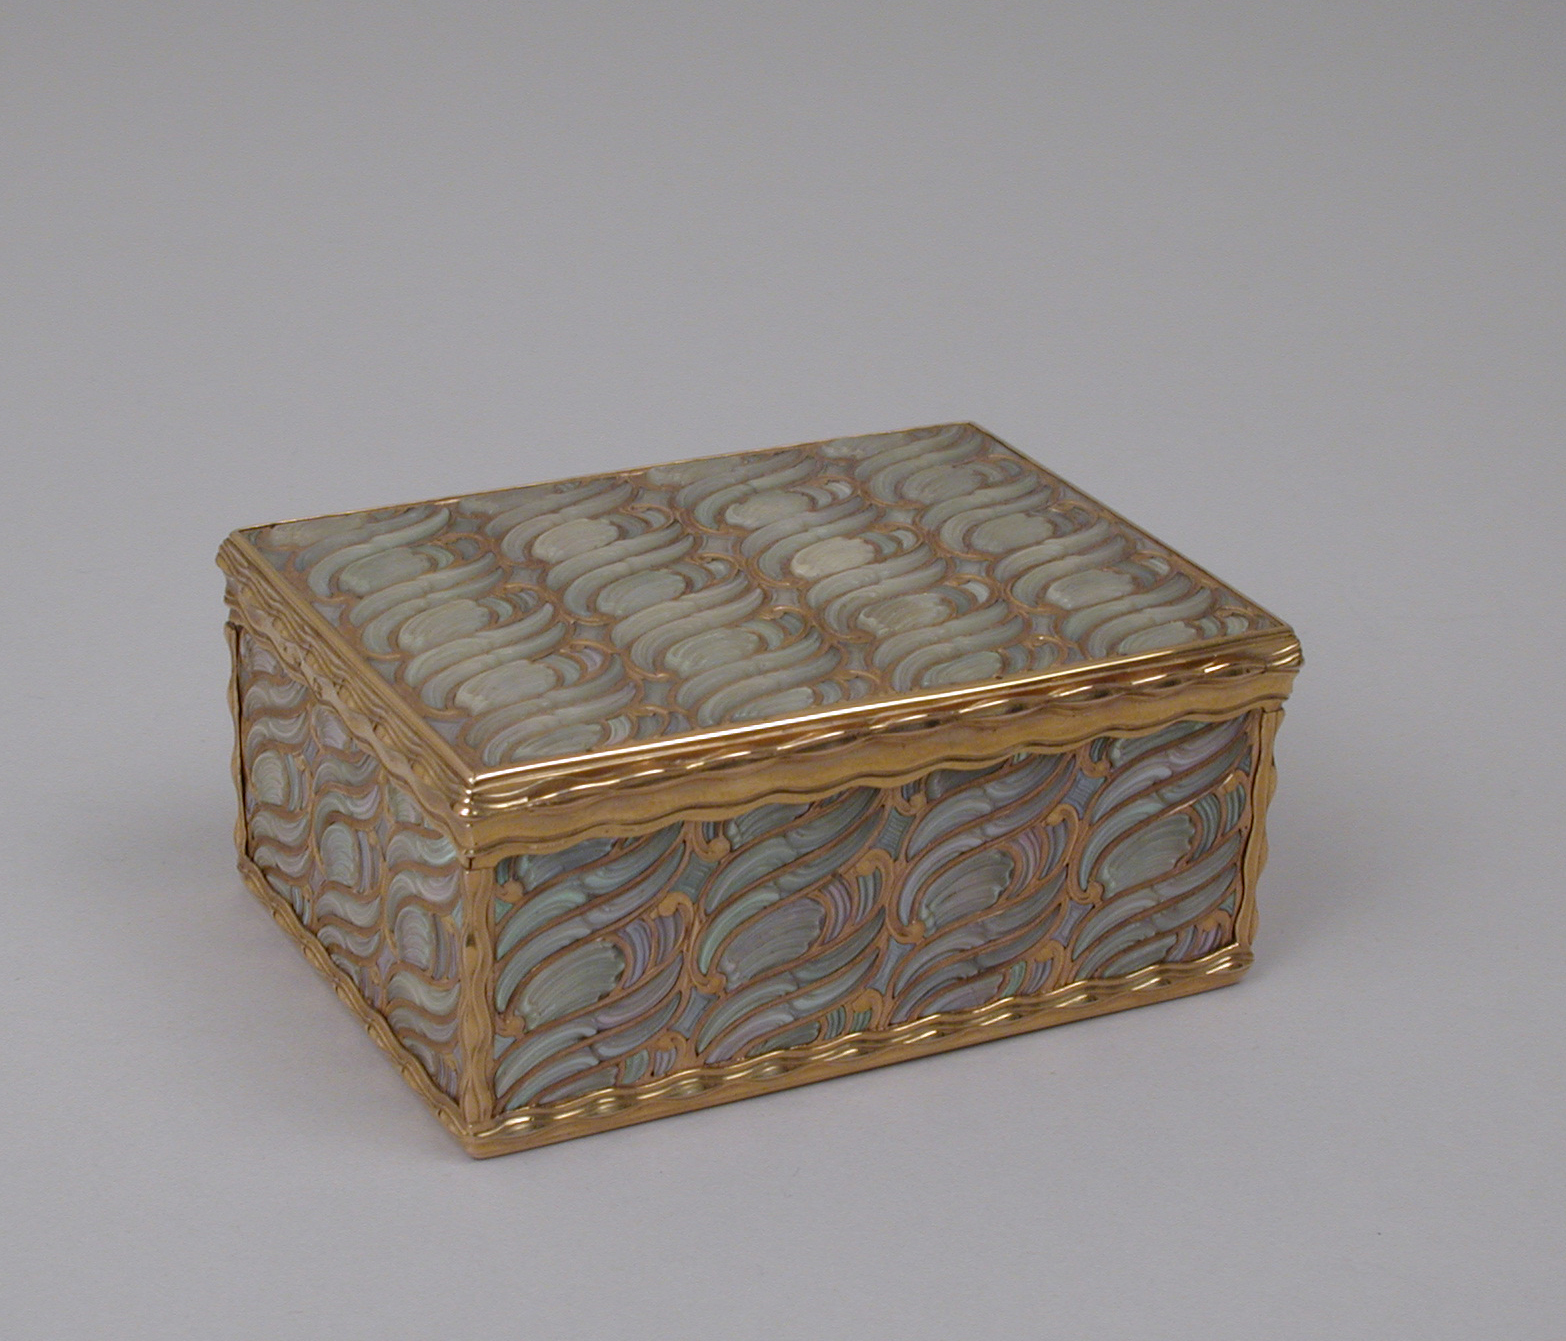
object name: snuffbox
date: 1744-1745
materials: gold, mother of pearl